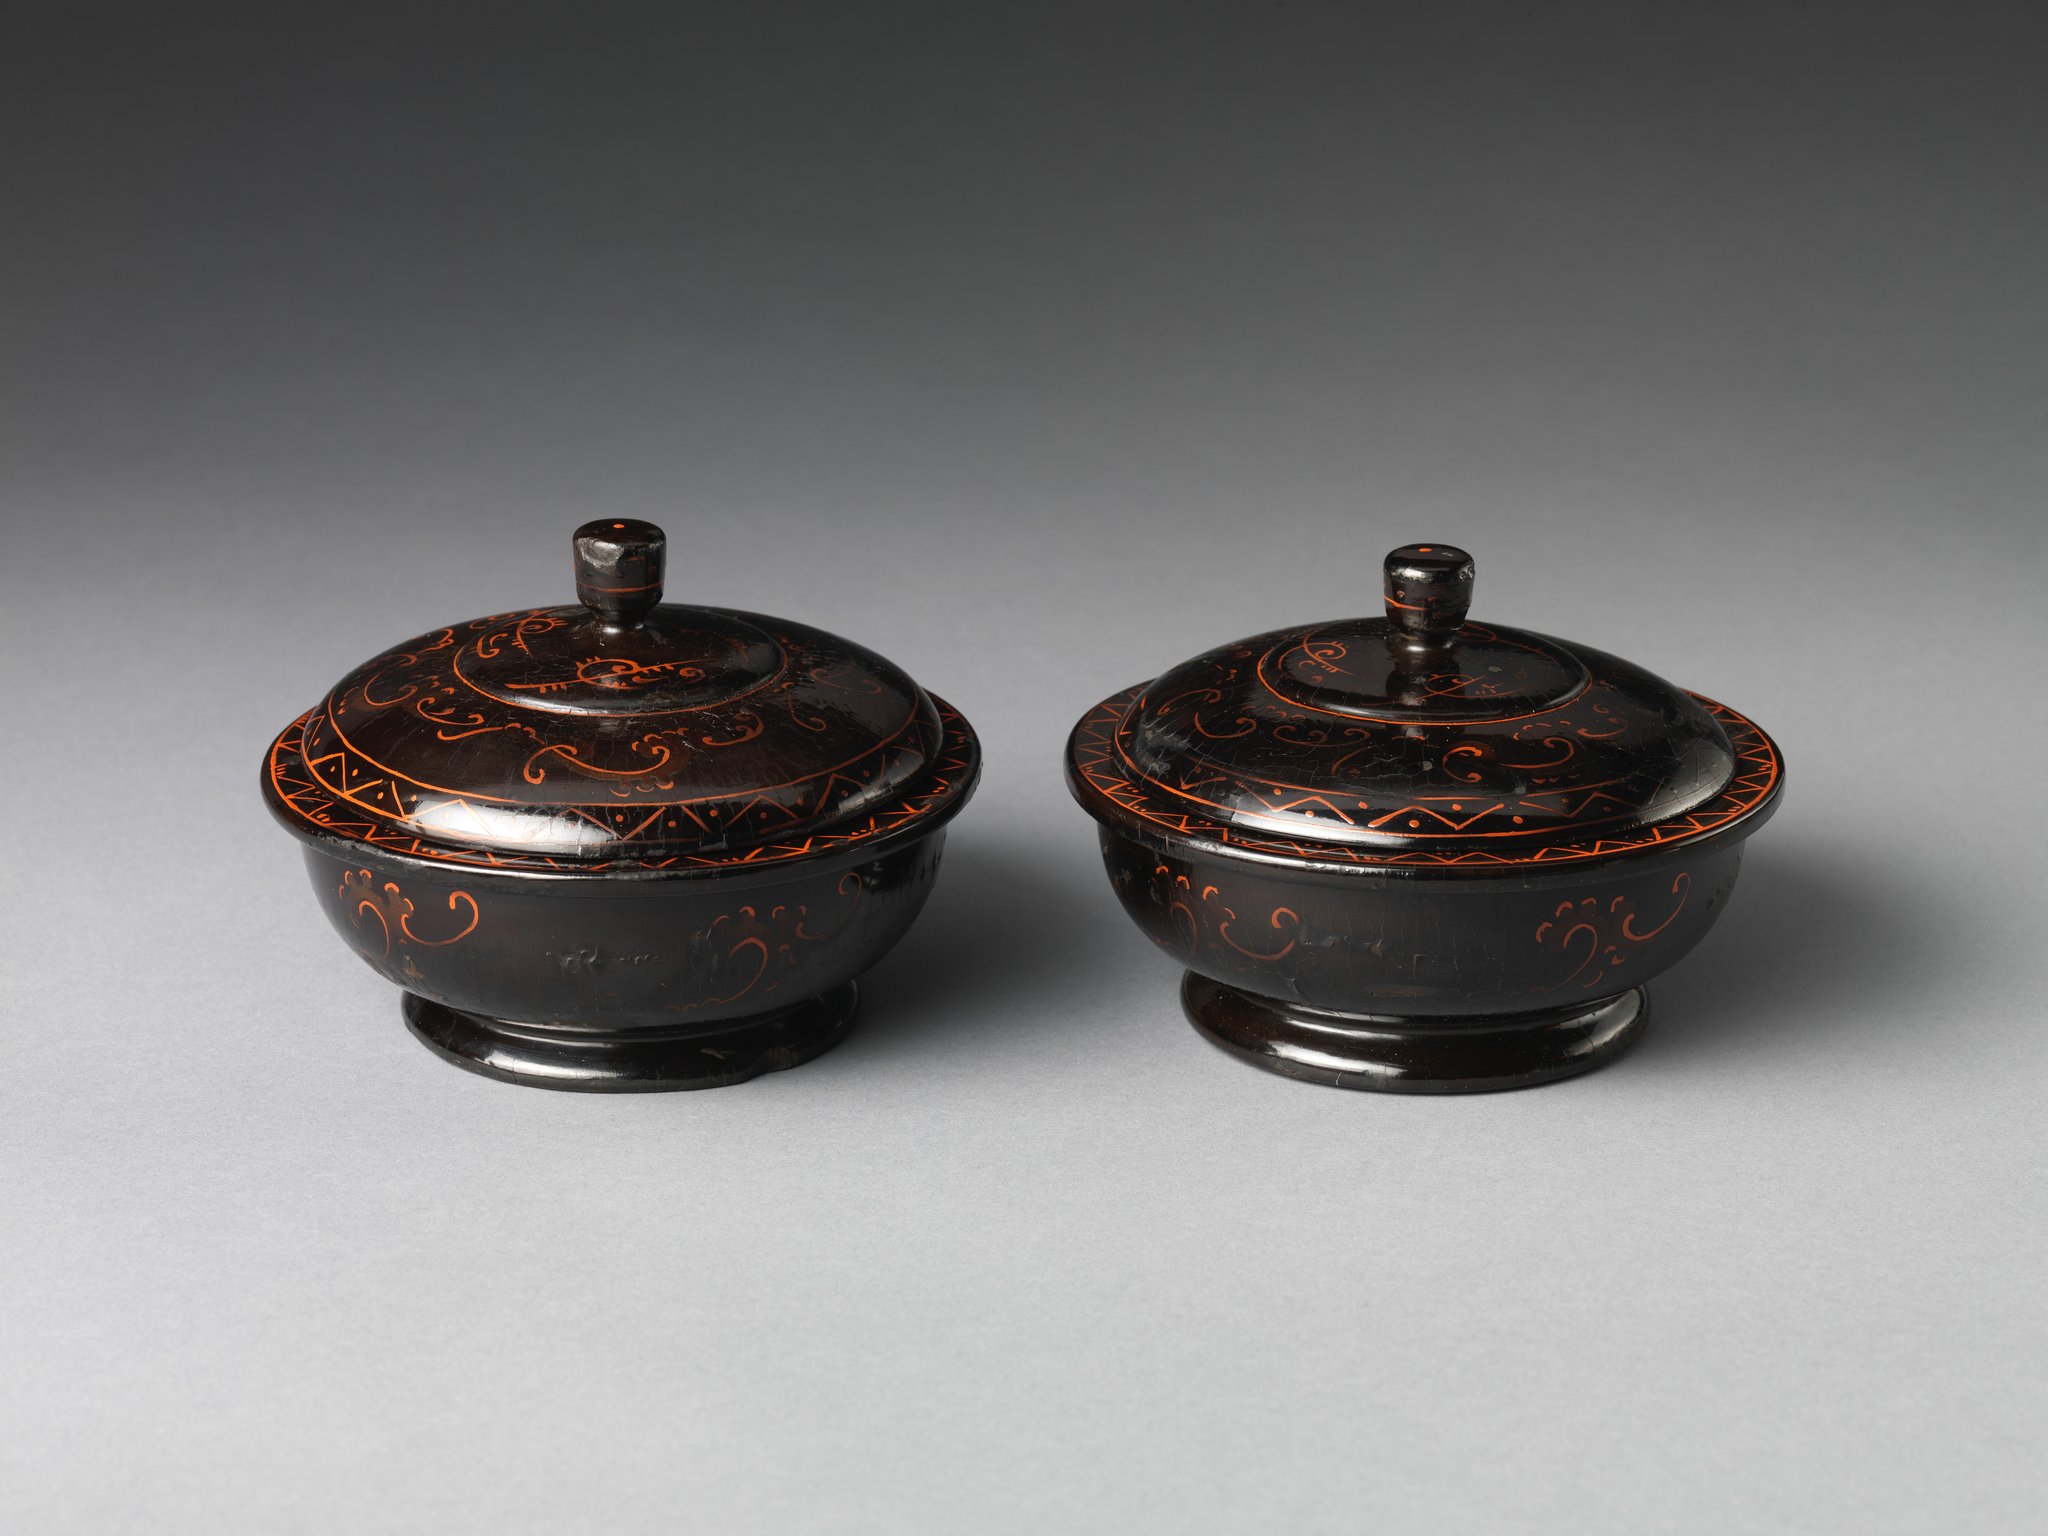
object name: bowl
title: Two Bowls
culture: chinese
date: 101-300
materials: lacquer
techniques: painting